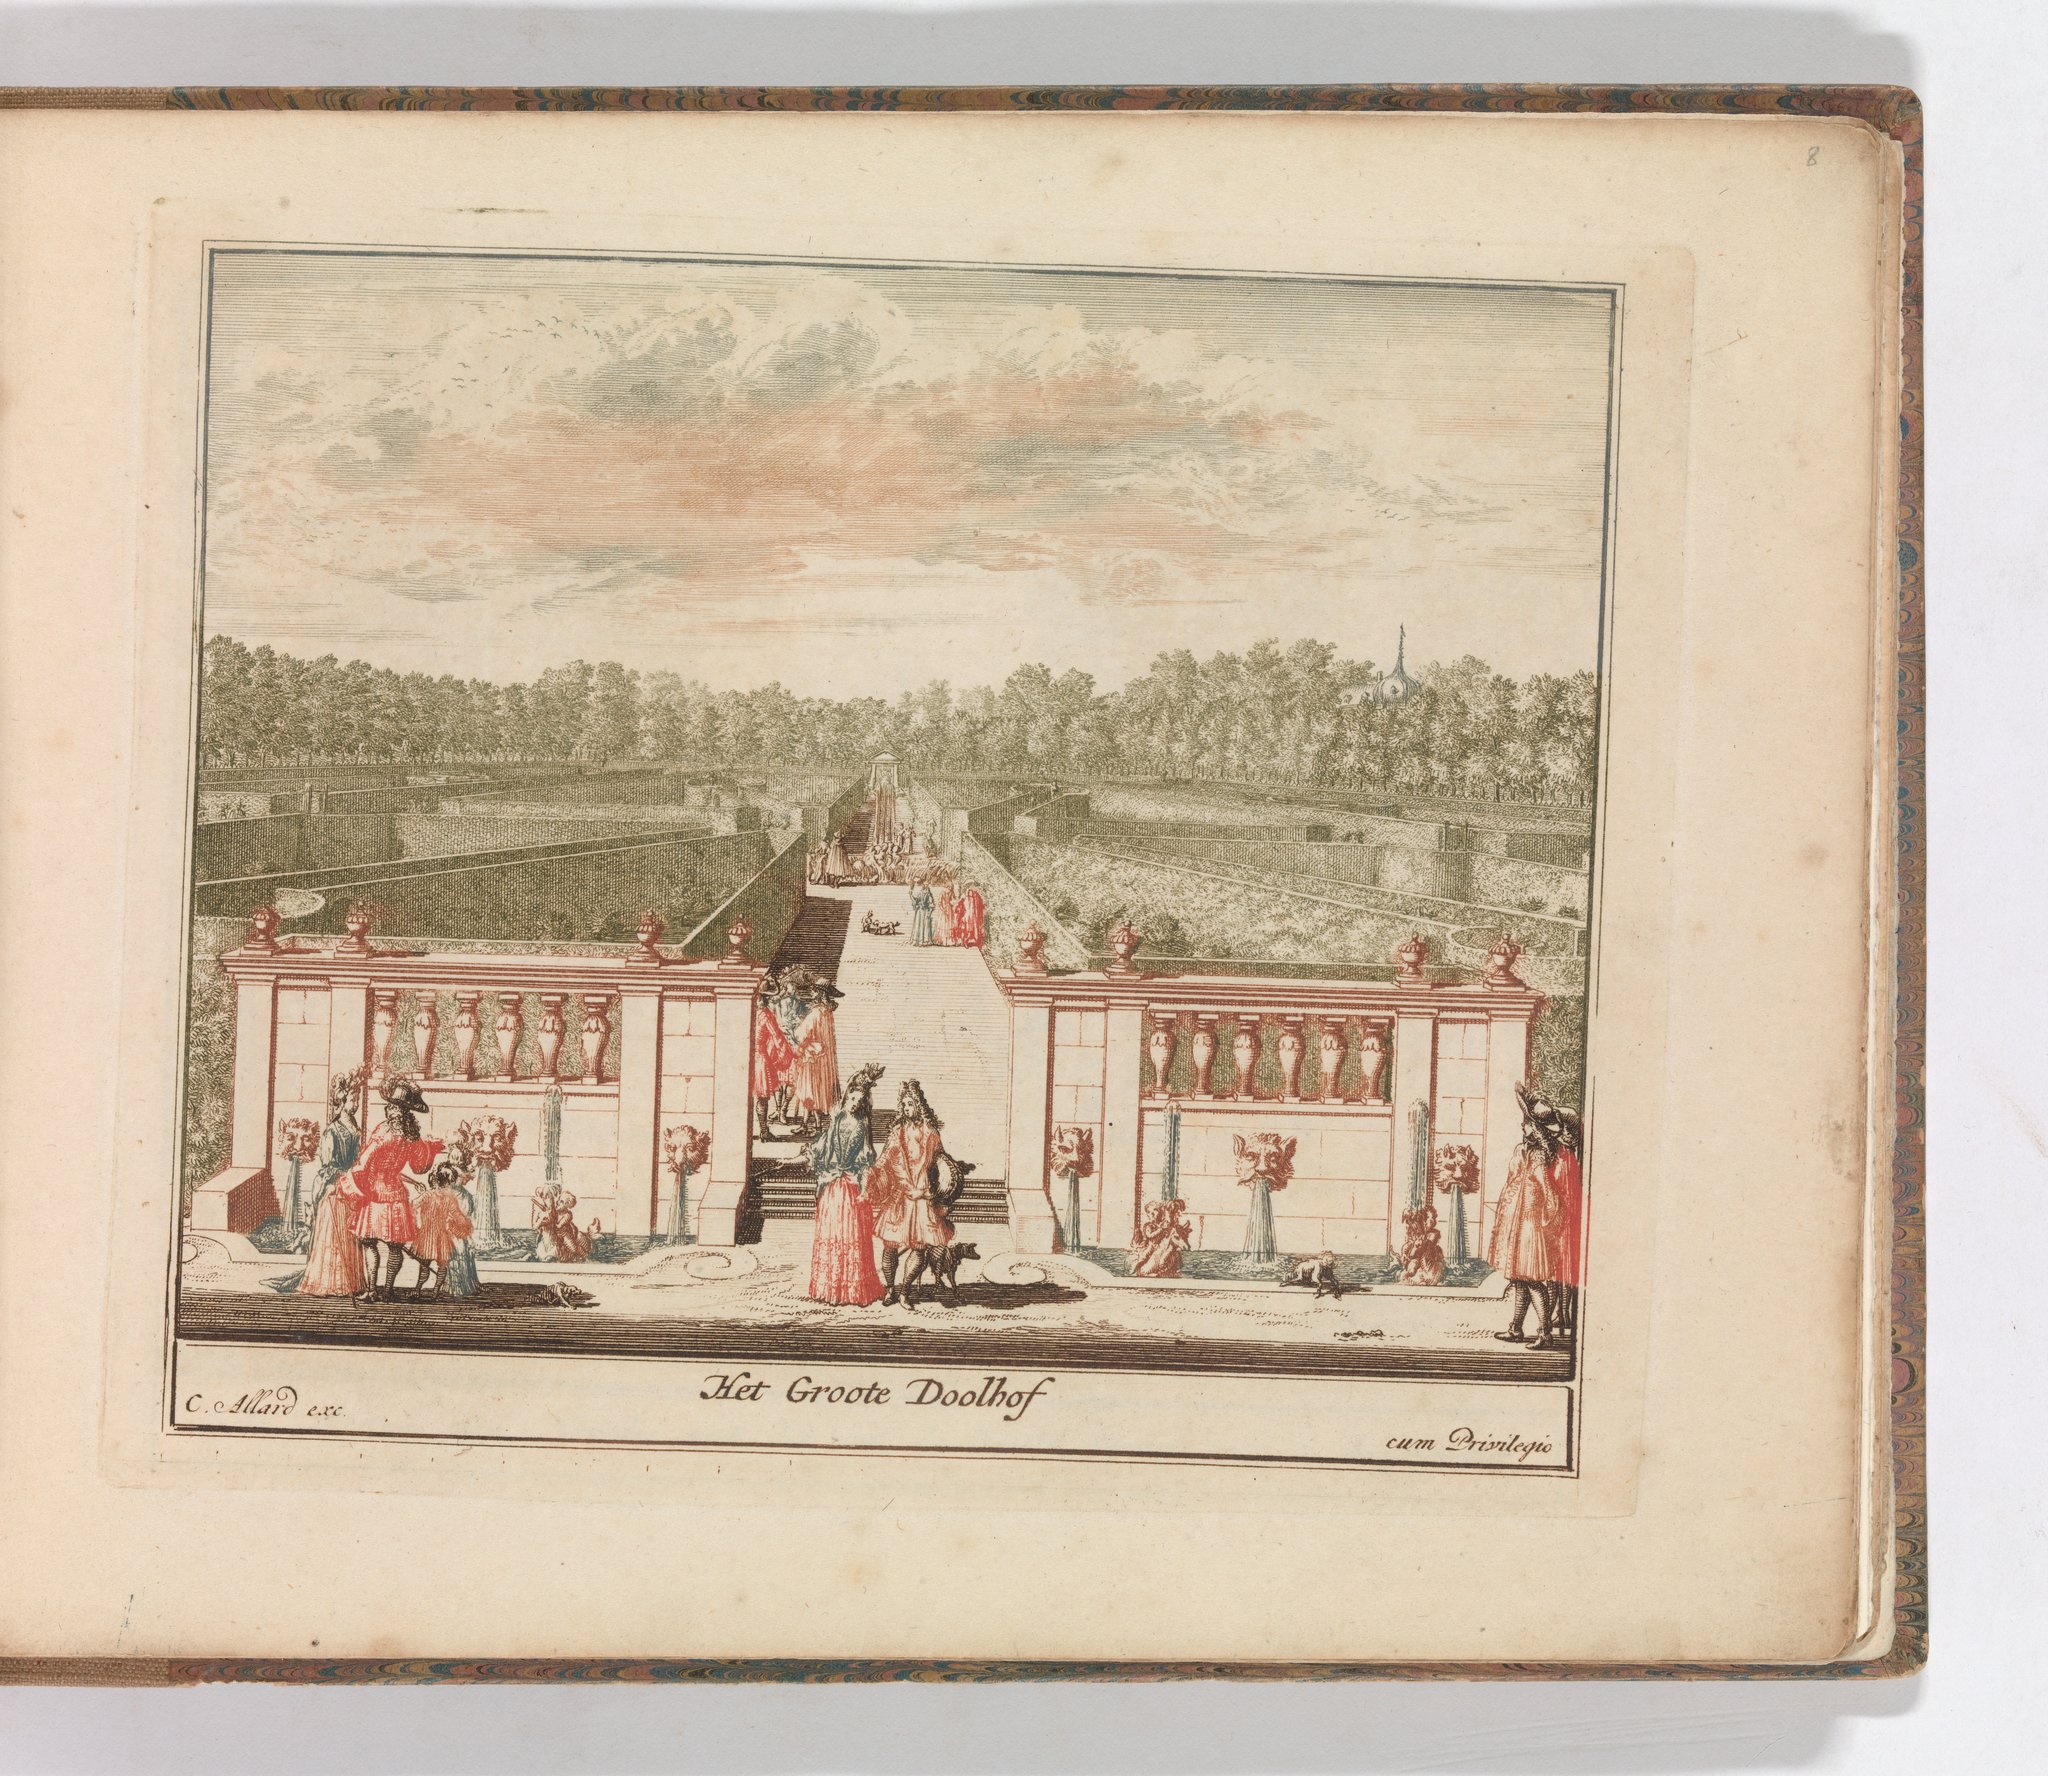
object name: book print ornament architecture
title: 'Het Groote Doolhof', in: Tooneel Der Voornaamste Nederlands Huizen, En Lust Hoven, Naar T Leven Afgebeeld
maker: carel allard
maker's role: publisher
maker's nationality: dutch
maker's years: 1648-1709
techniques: engraving, lithography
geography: amsterdam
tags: gardens,men,women